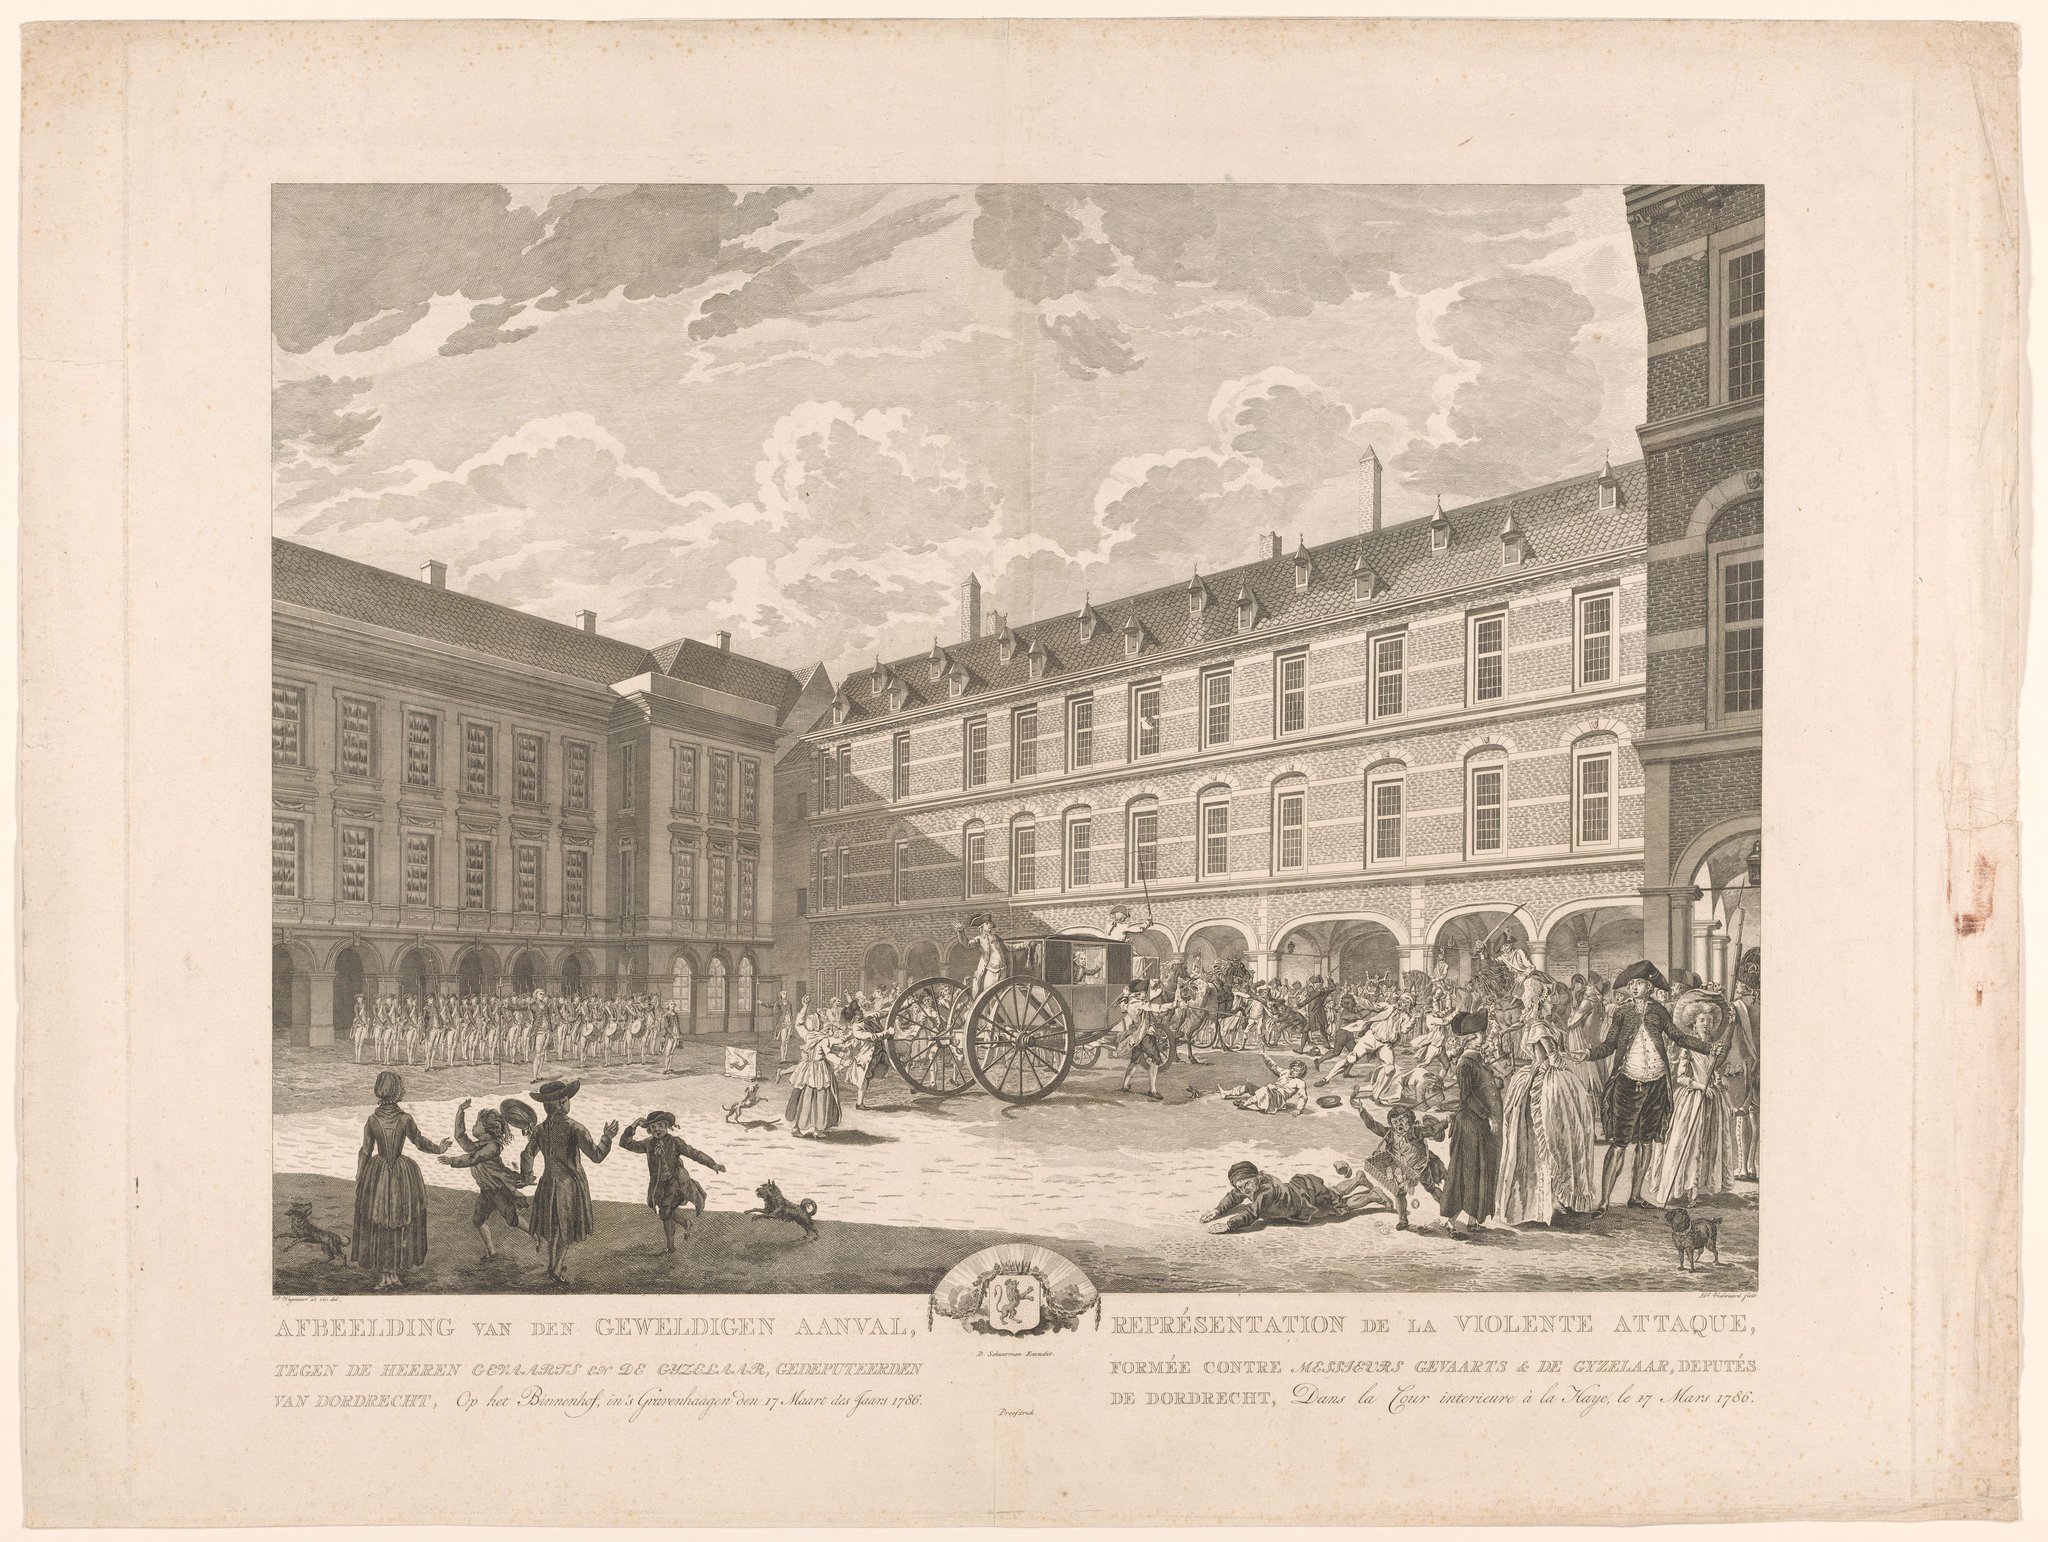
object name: print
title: Afbeelding van den Geweldigen Aanval, tegen de heeren Gevaarts en De Gyzelaar, gedeputeerden van Dordrecht, Op het Binnenhof, in 's Gravenhaagen den 17 Maart des Jaars 1786 / Représentation de la Violente Attaque (...)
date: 1790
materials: paper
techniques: engraving, etching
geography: netherlands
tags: revolutionary action (violent)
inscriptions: collector's mark: Lugt 2228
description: Ongeregeldheden als de gedeputeerden van Dordrecht, de heren Gevaerts en De Gijzelaar, met hun rijtuig door de Stadhouderspoort het Binnenhof op rijden en hun paarden bij de toom worden gegrepen door de Haagse pruikenmaker F. Mourand, 17 maart 1786. Links de opgestelde schutterij, centraal verdedigt de advocaat Van Nispen de koets.